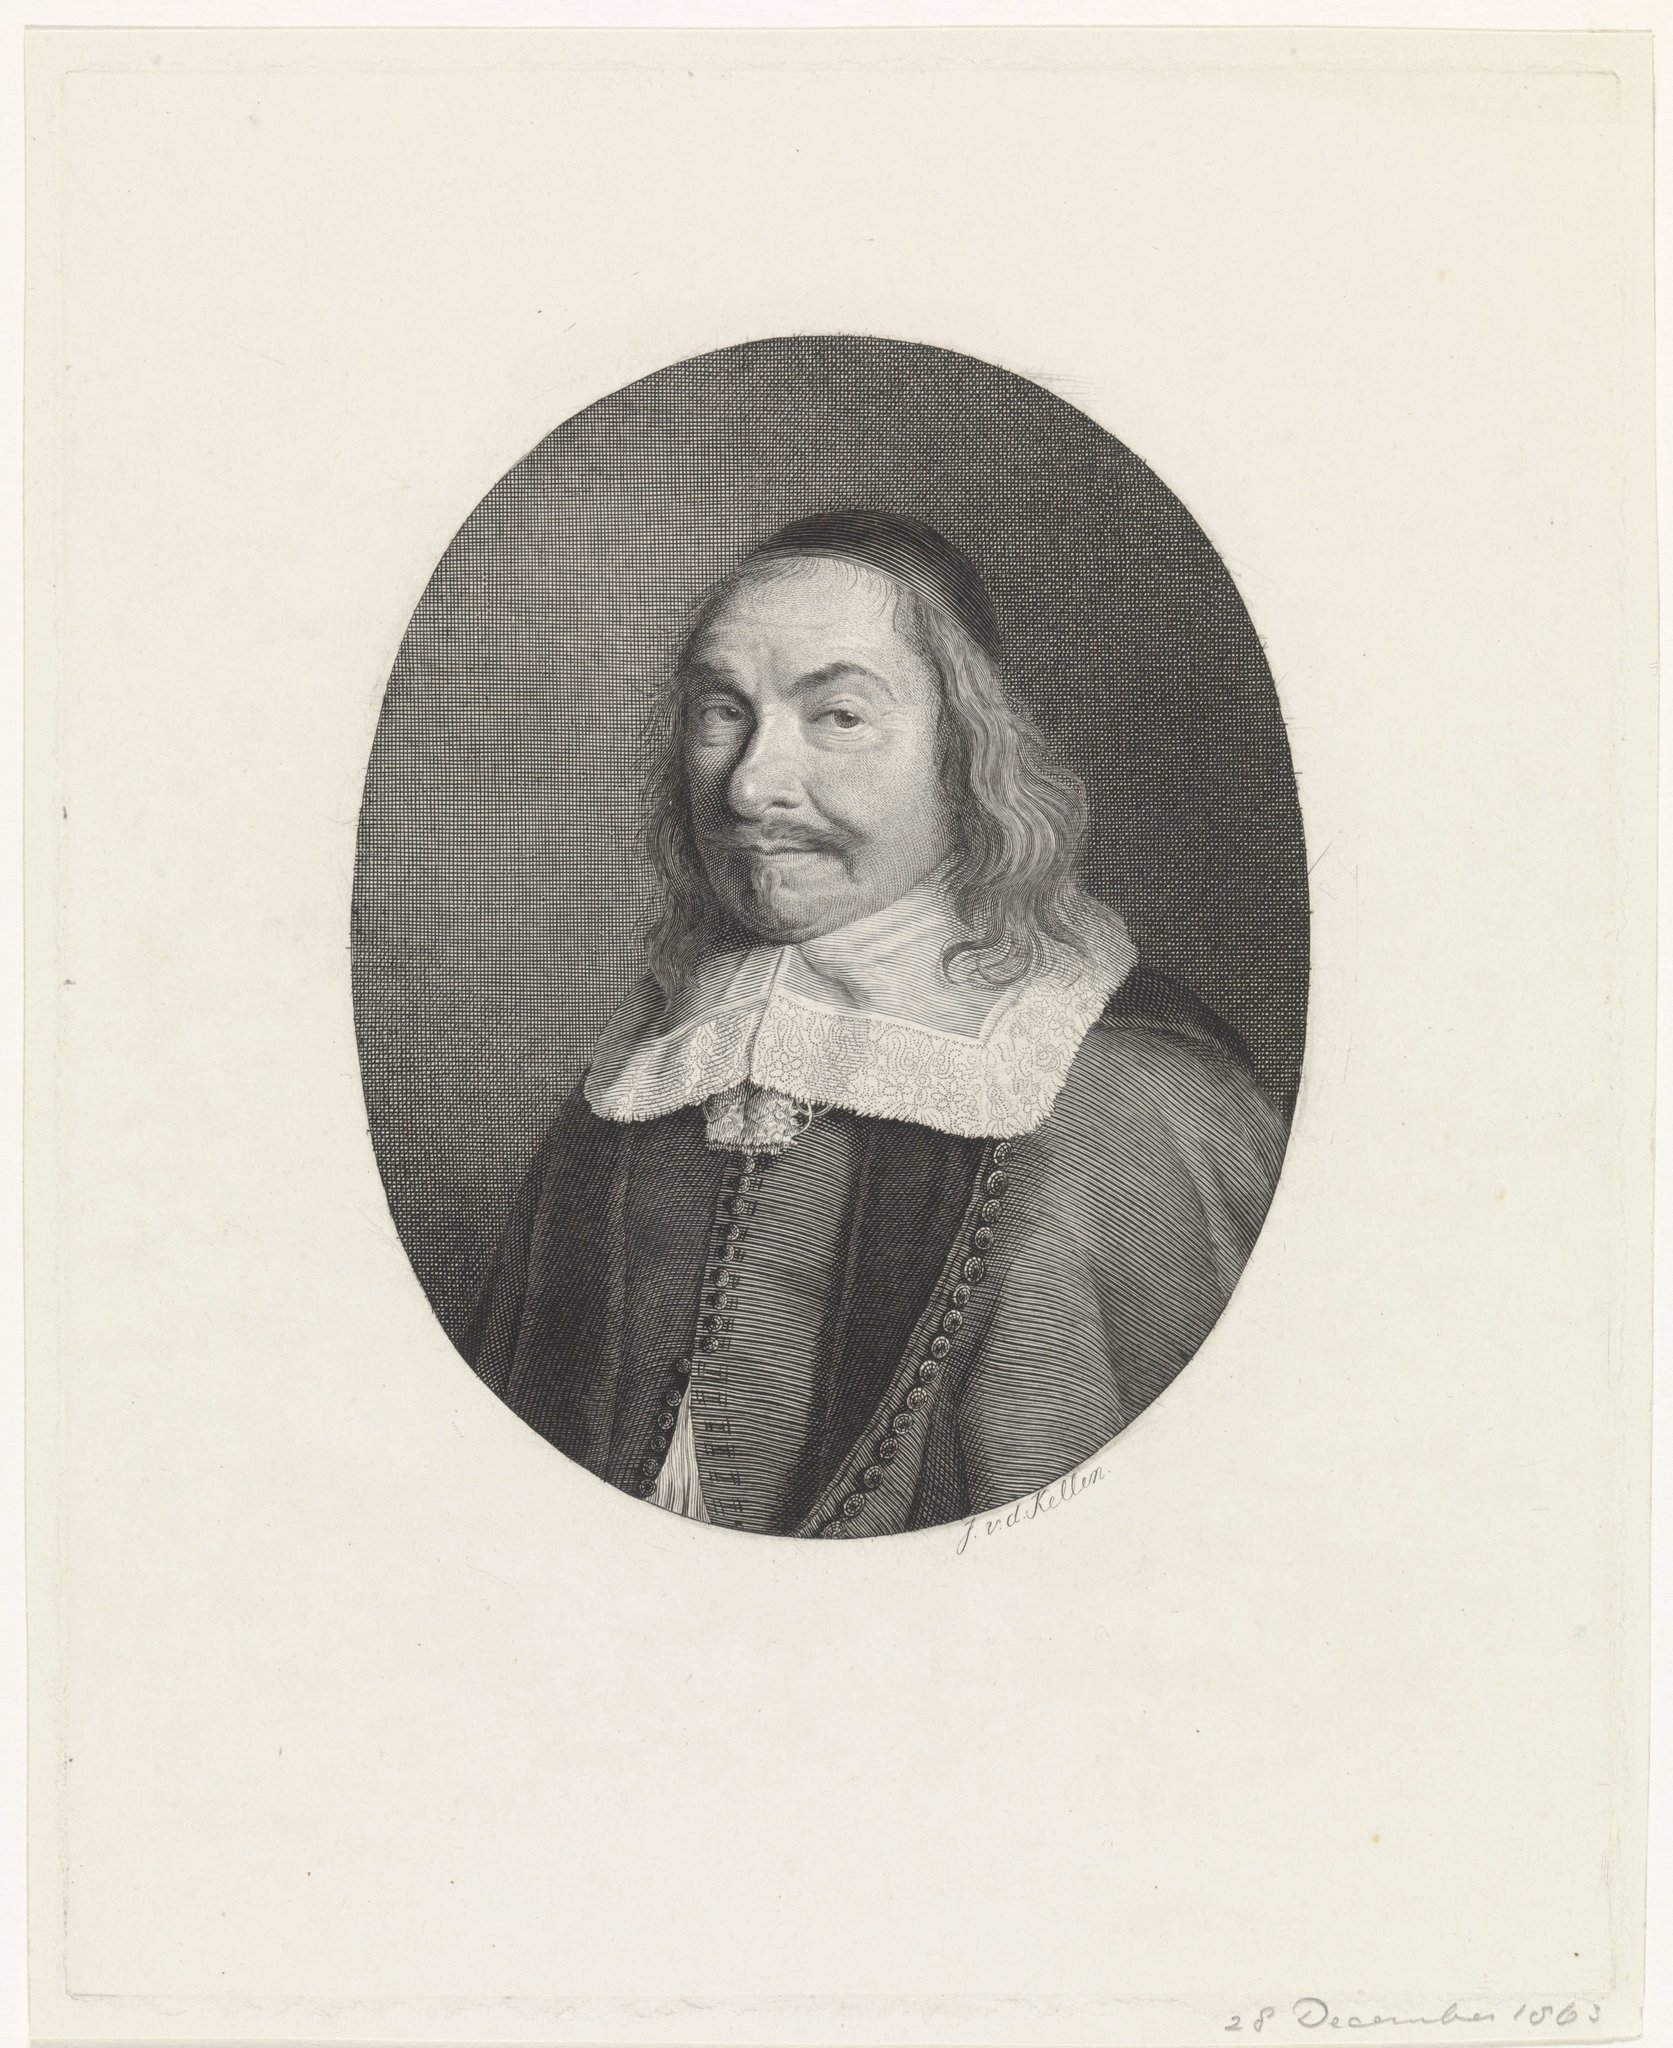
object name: print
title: Portret van Jean Loret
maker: johannes van der kellen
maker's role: print maker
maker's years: 1843-1895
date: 1863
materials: paper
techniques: engraving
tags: dichter, jean loret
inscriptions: inscription: ‘28 December 1863’, collector's mark: Lugt 2228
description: Portretbuste in een ovaal van de dichter Jean Loret, driekwart naar links. Zijn hoofd is getooid met een kalot en zijn kraag heeft een rand van kant.